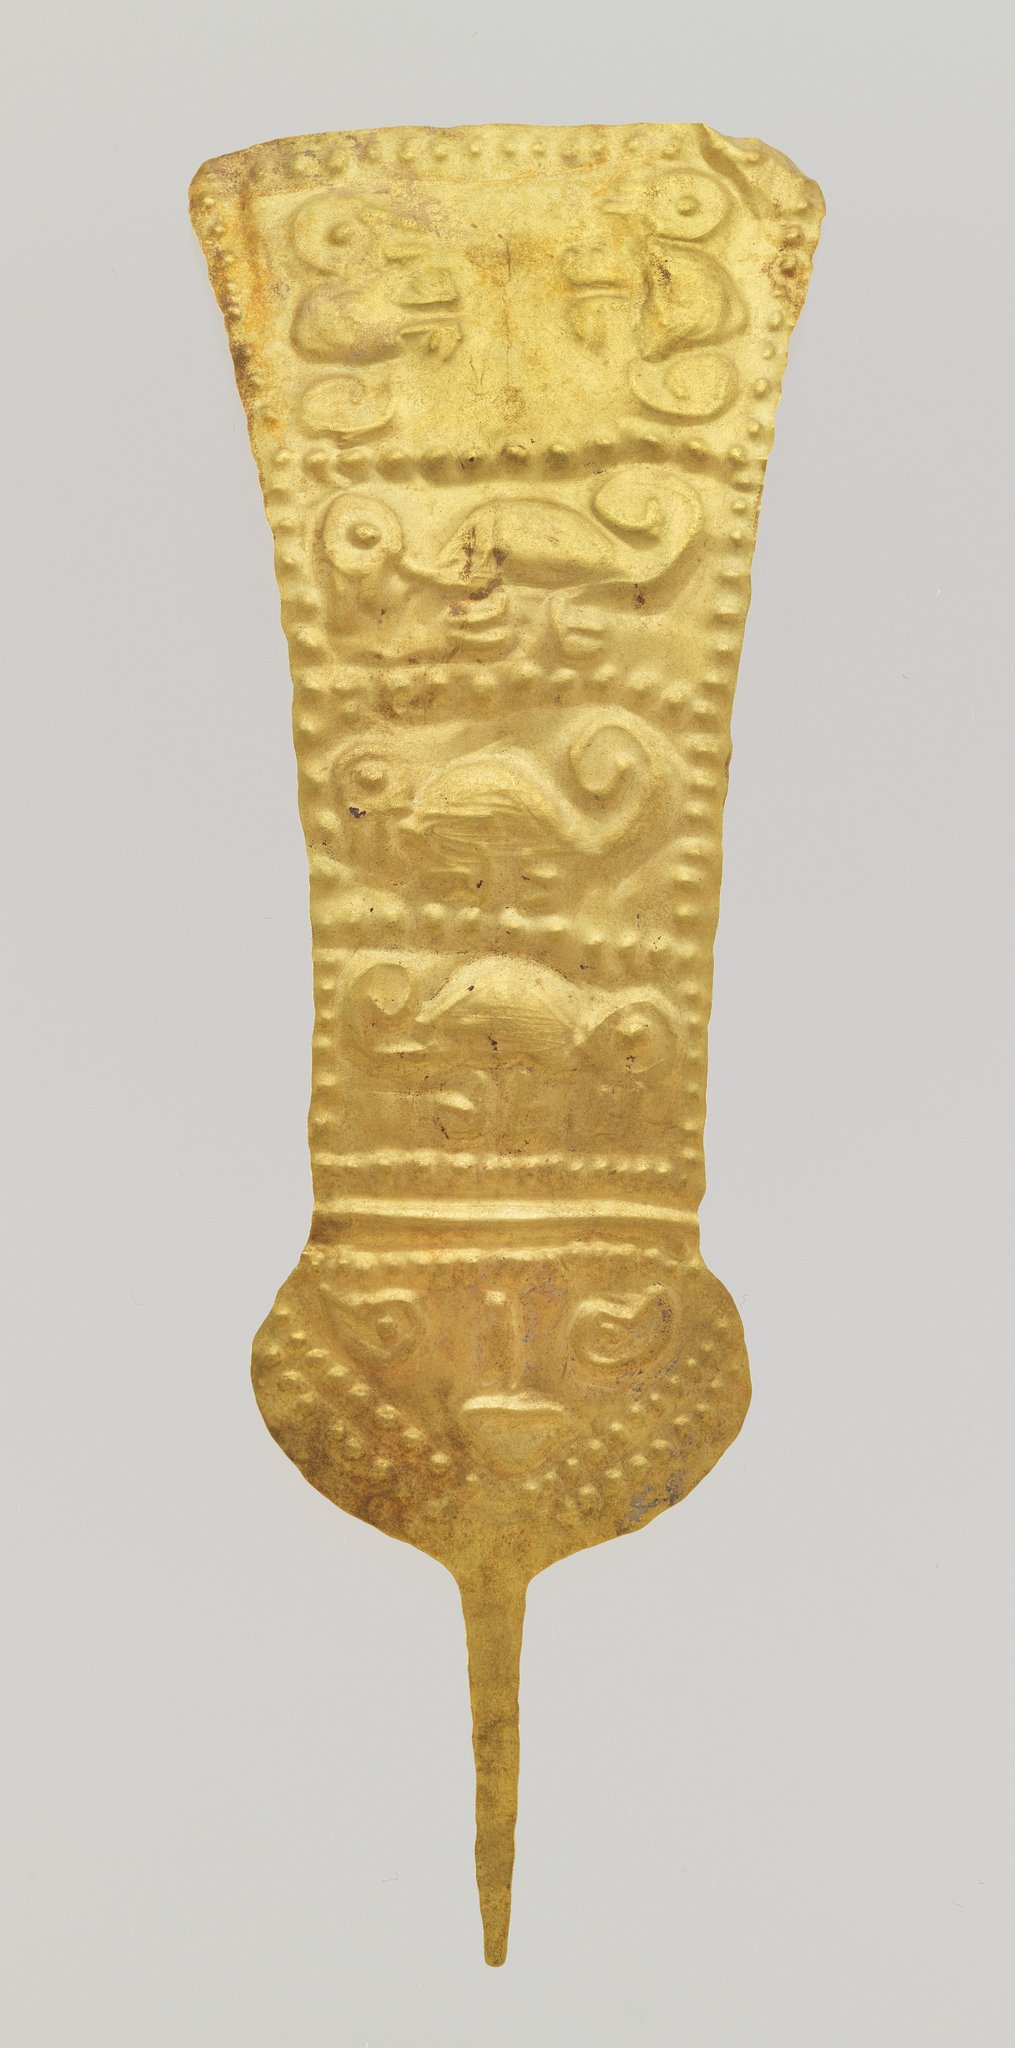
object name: ornament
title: Plume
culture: lambayeque, sicán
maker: lambayeque (sicán) artist(s)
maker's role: artist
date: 900-1375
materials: gold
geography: peru